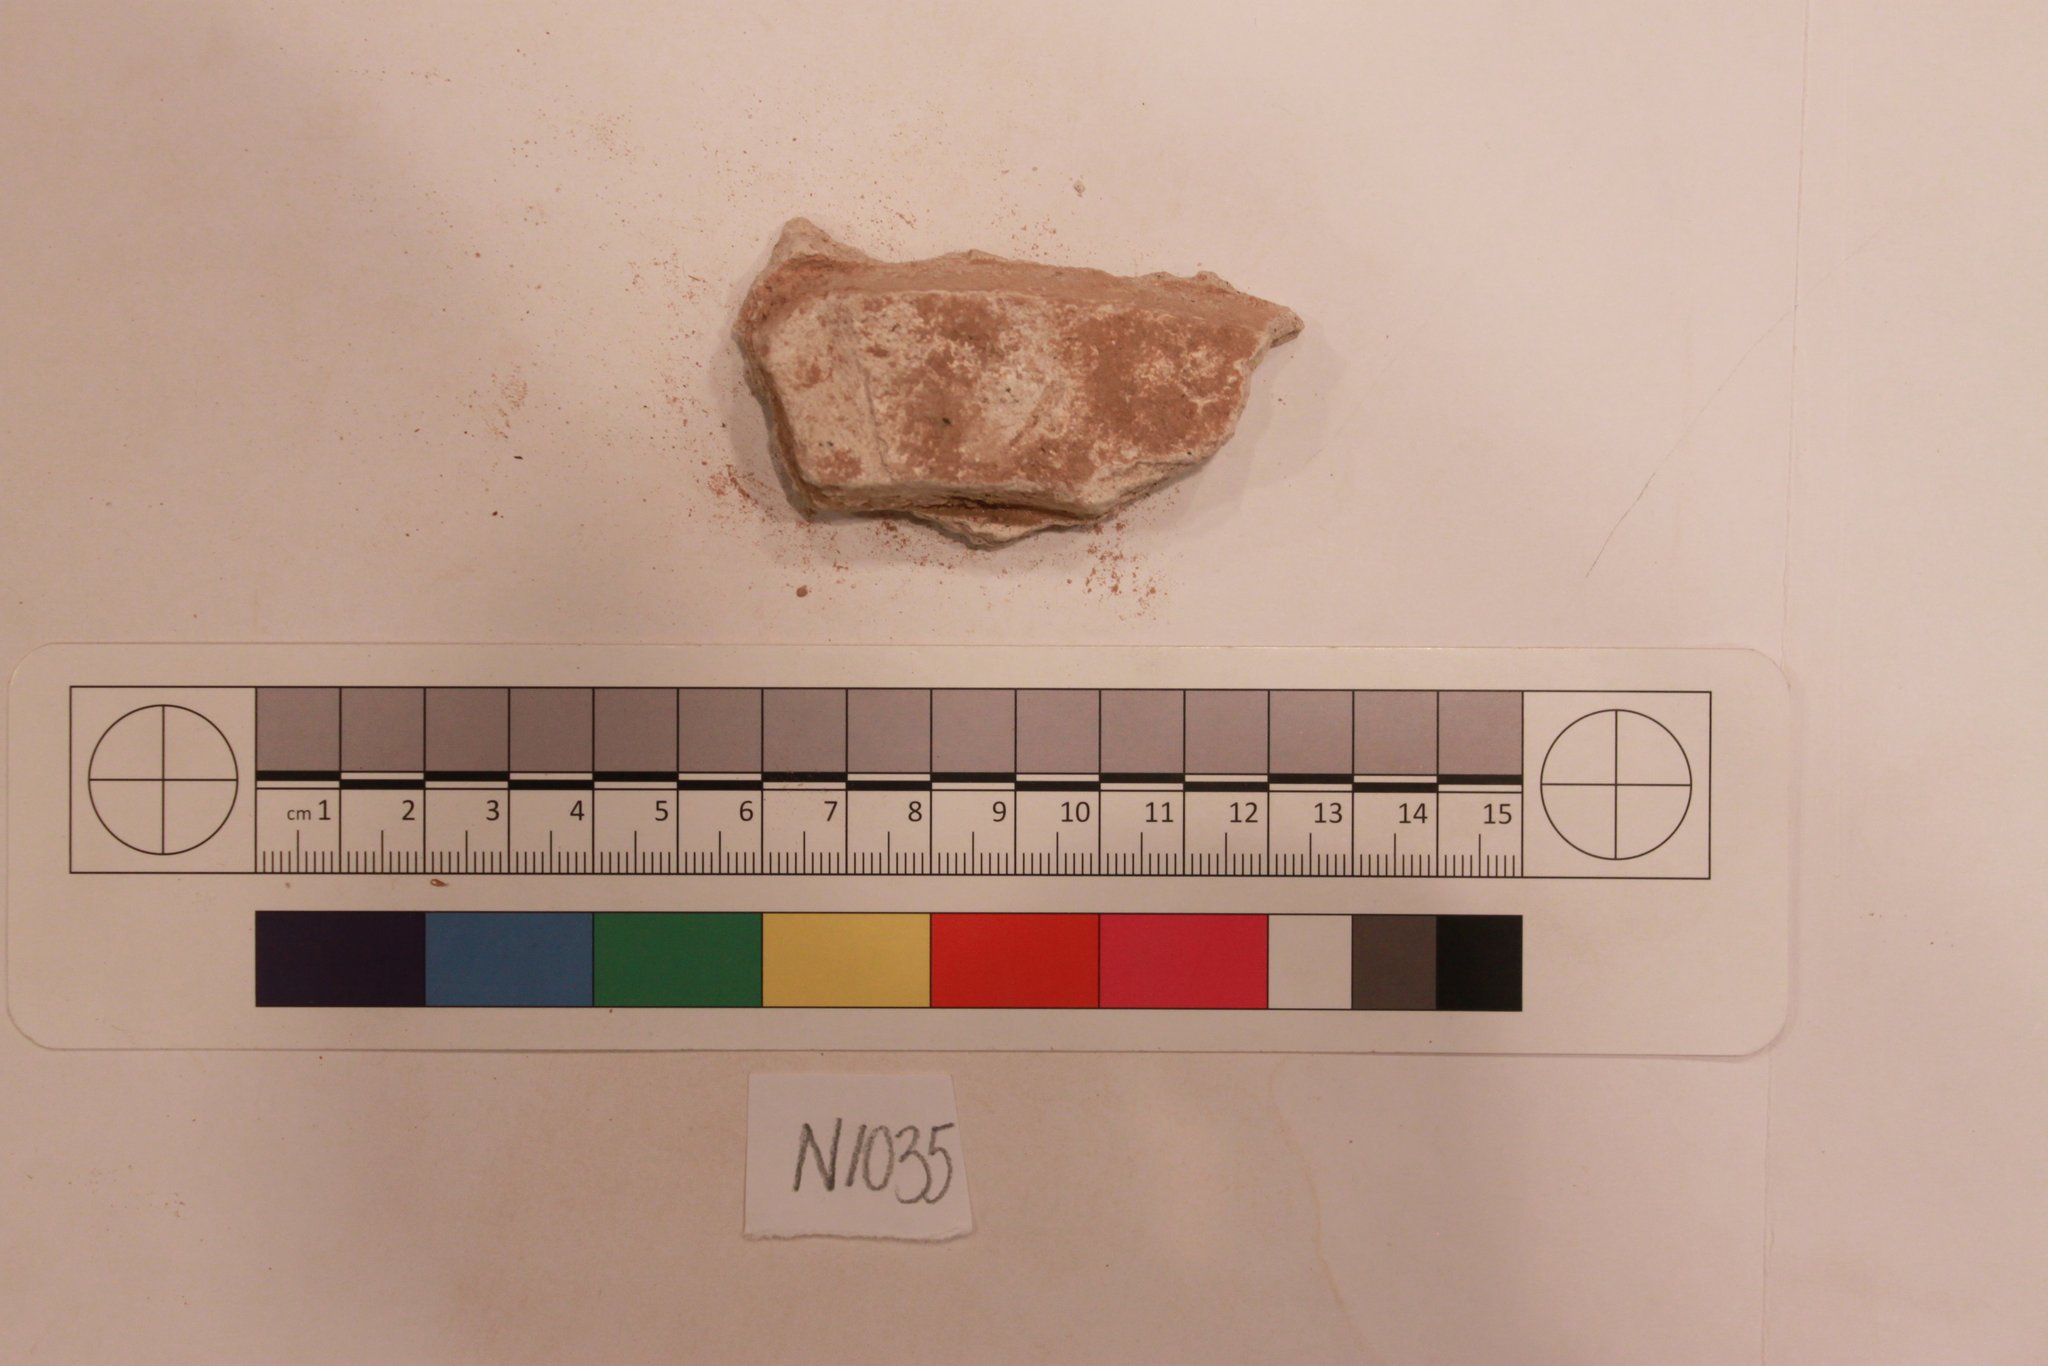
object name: fragment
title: Stucco Fragment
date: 701-1200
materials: plaster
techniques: carving, painting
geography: iran